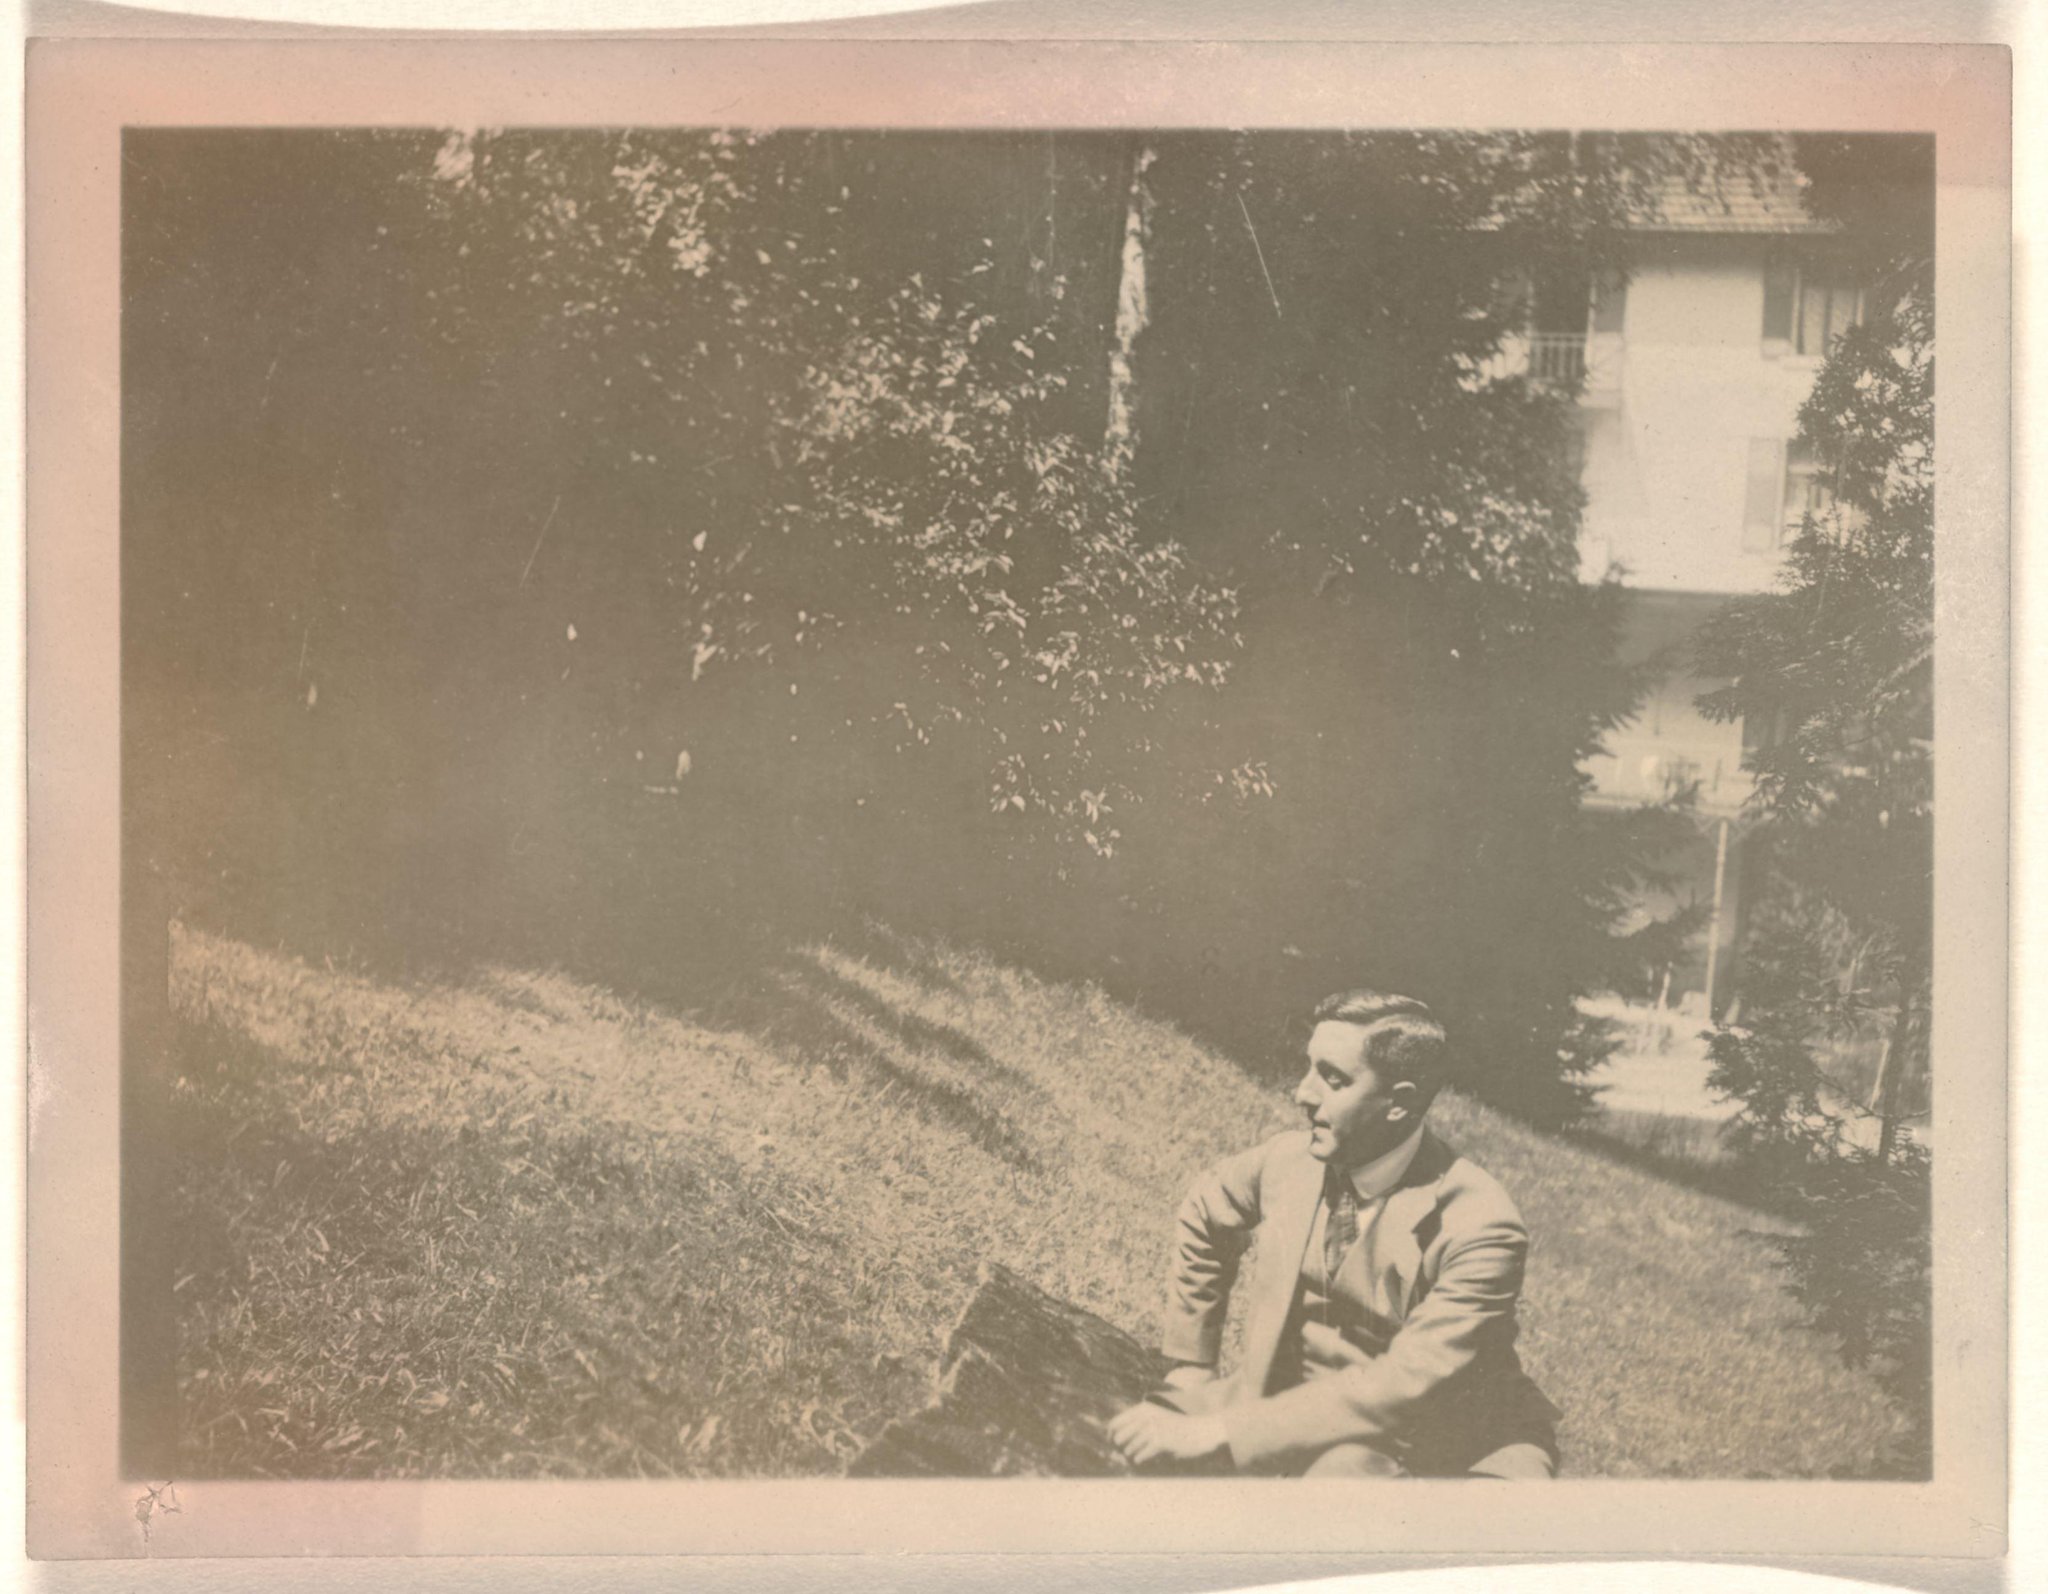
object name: photograph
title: Eugen Wachenheimer, zittend in een tuin in Baden-Baden, 1913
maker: Anonymous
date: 1913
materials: photographic support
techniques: gelatin silver print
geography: baden-baden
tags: eugen wachenheimer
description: Eugen Wachenheimer, zittend in een tuin in Baden-Baden.